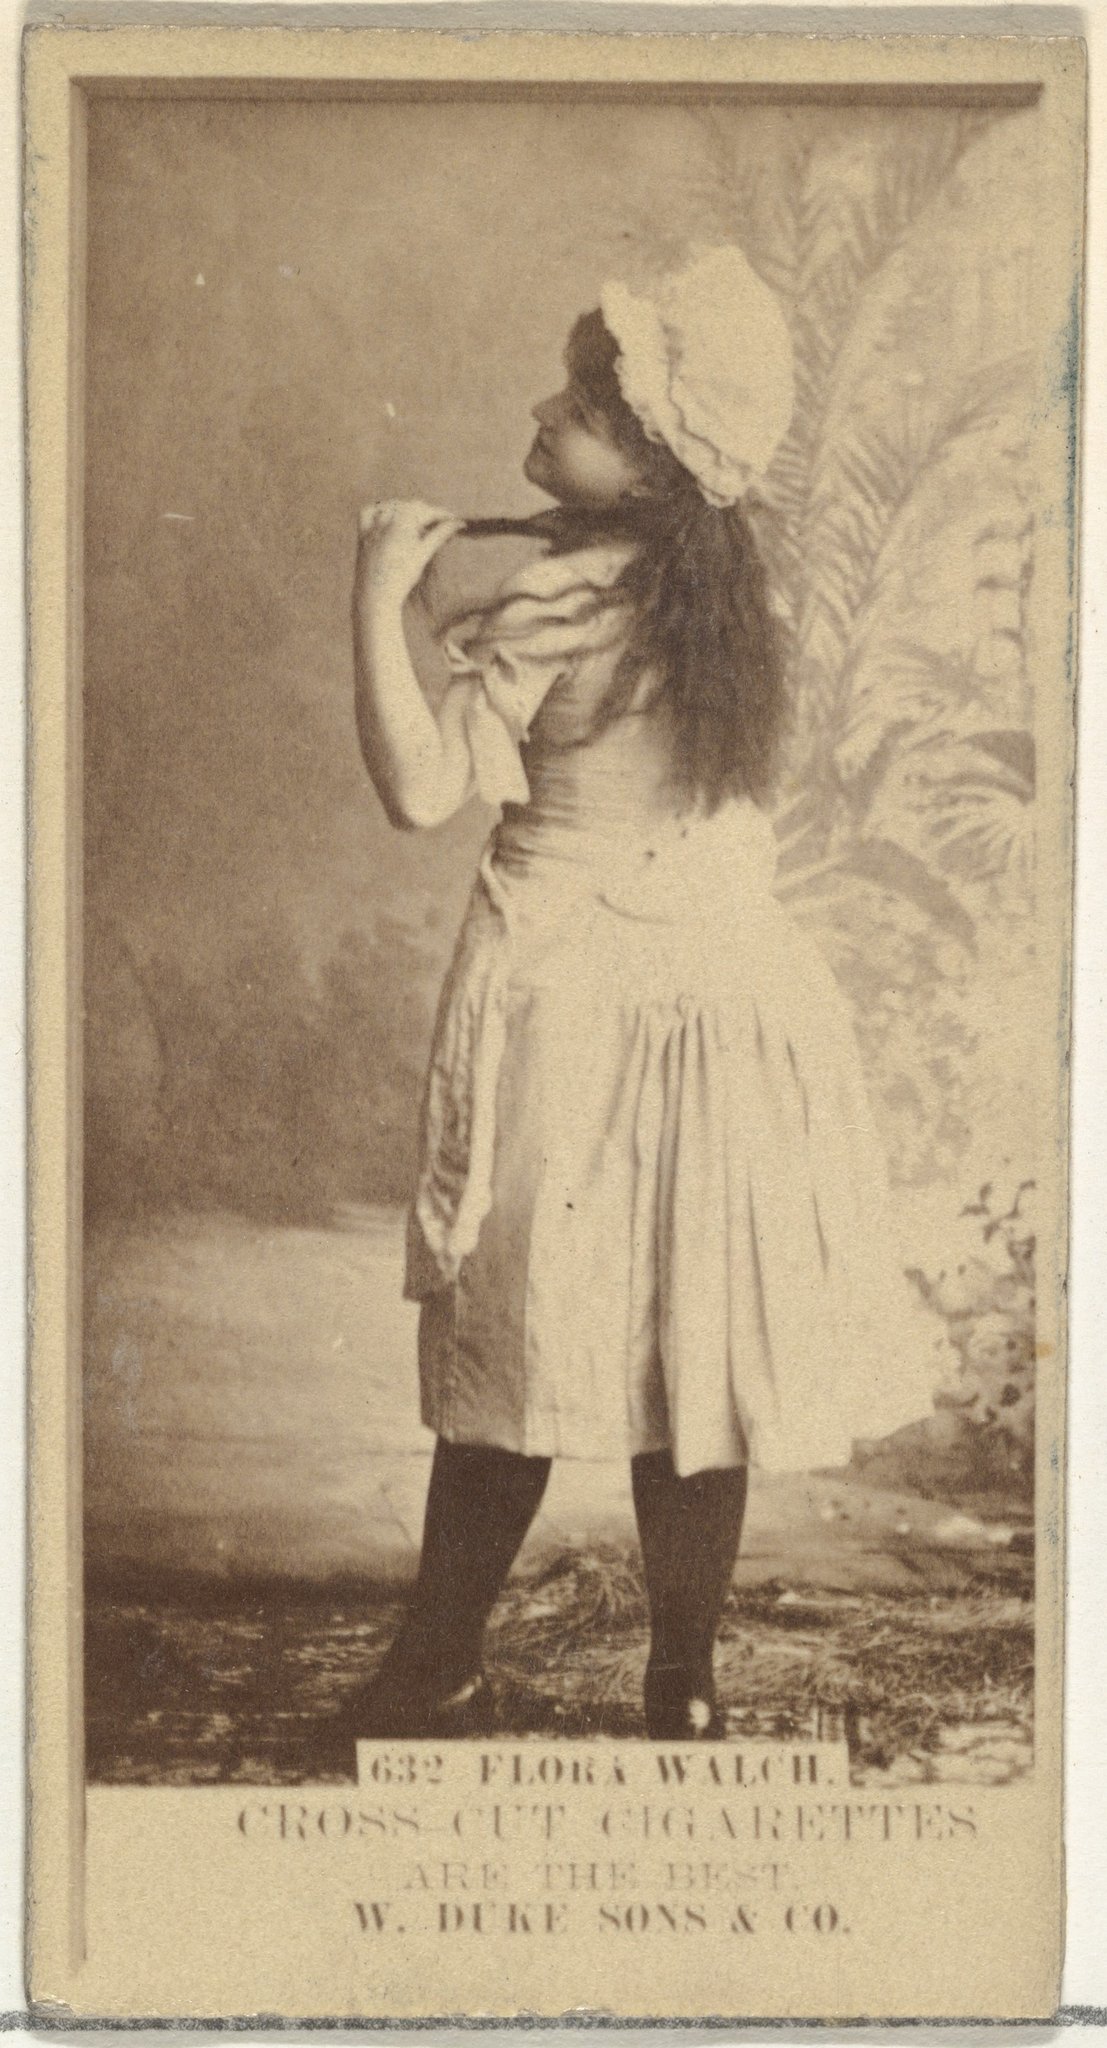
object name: photograph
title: Card Number 632, Flora Walch, from the Actors and Actresses series (N145-3) issued by Duke Sons & Co. to promote Cross Cut Cigarettes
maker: w. duke, sons & co.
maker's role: publisher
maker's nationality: american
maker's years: 1870-1920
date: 1880-1889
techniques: albumen silver print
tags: portraits,women,actresses